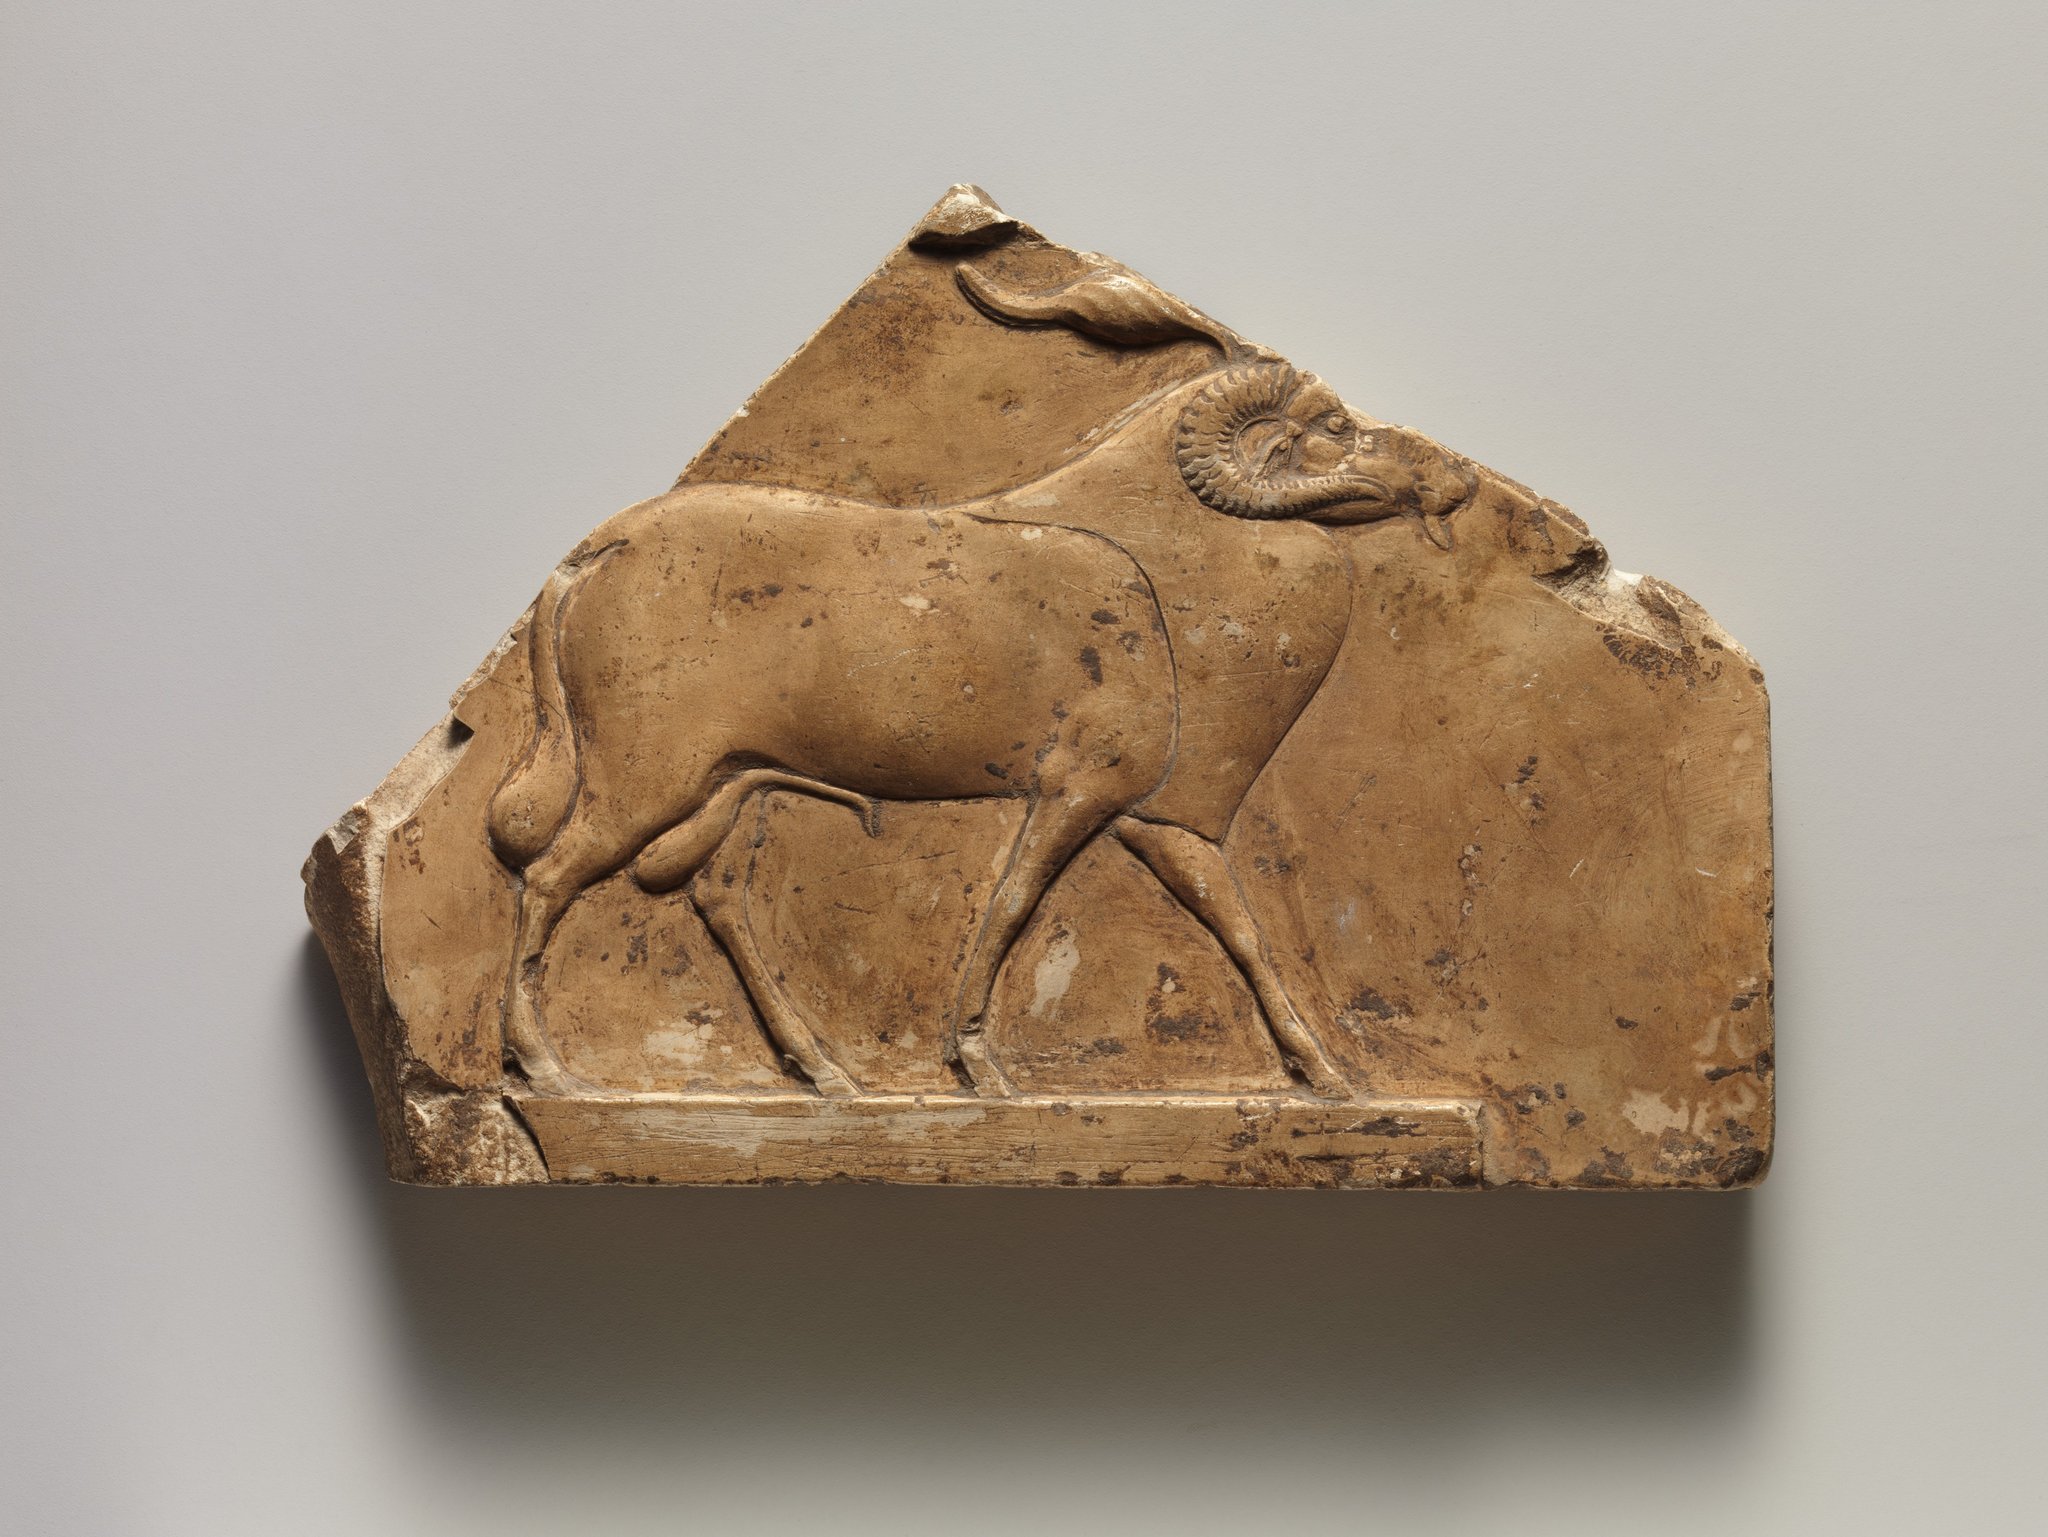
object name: sculptor's model votive, ram, two foot on opposite side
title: Relief plaque with ram, and on opposite side two feet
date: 400-30 BCE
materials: limestone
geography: egypt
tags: rams